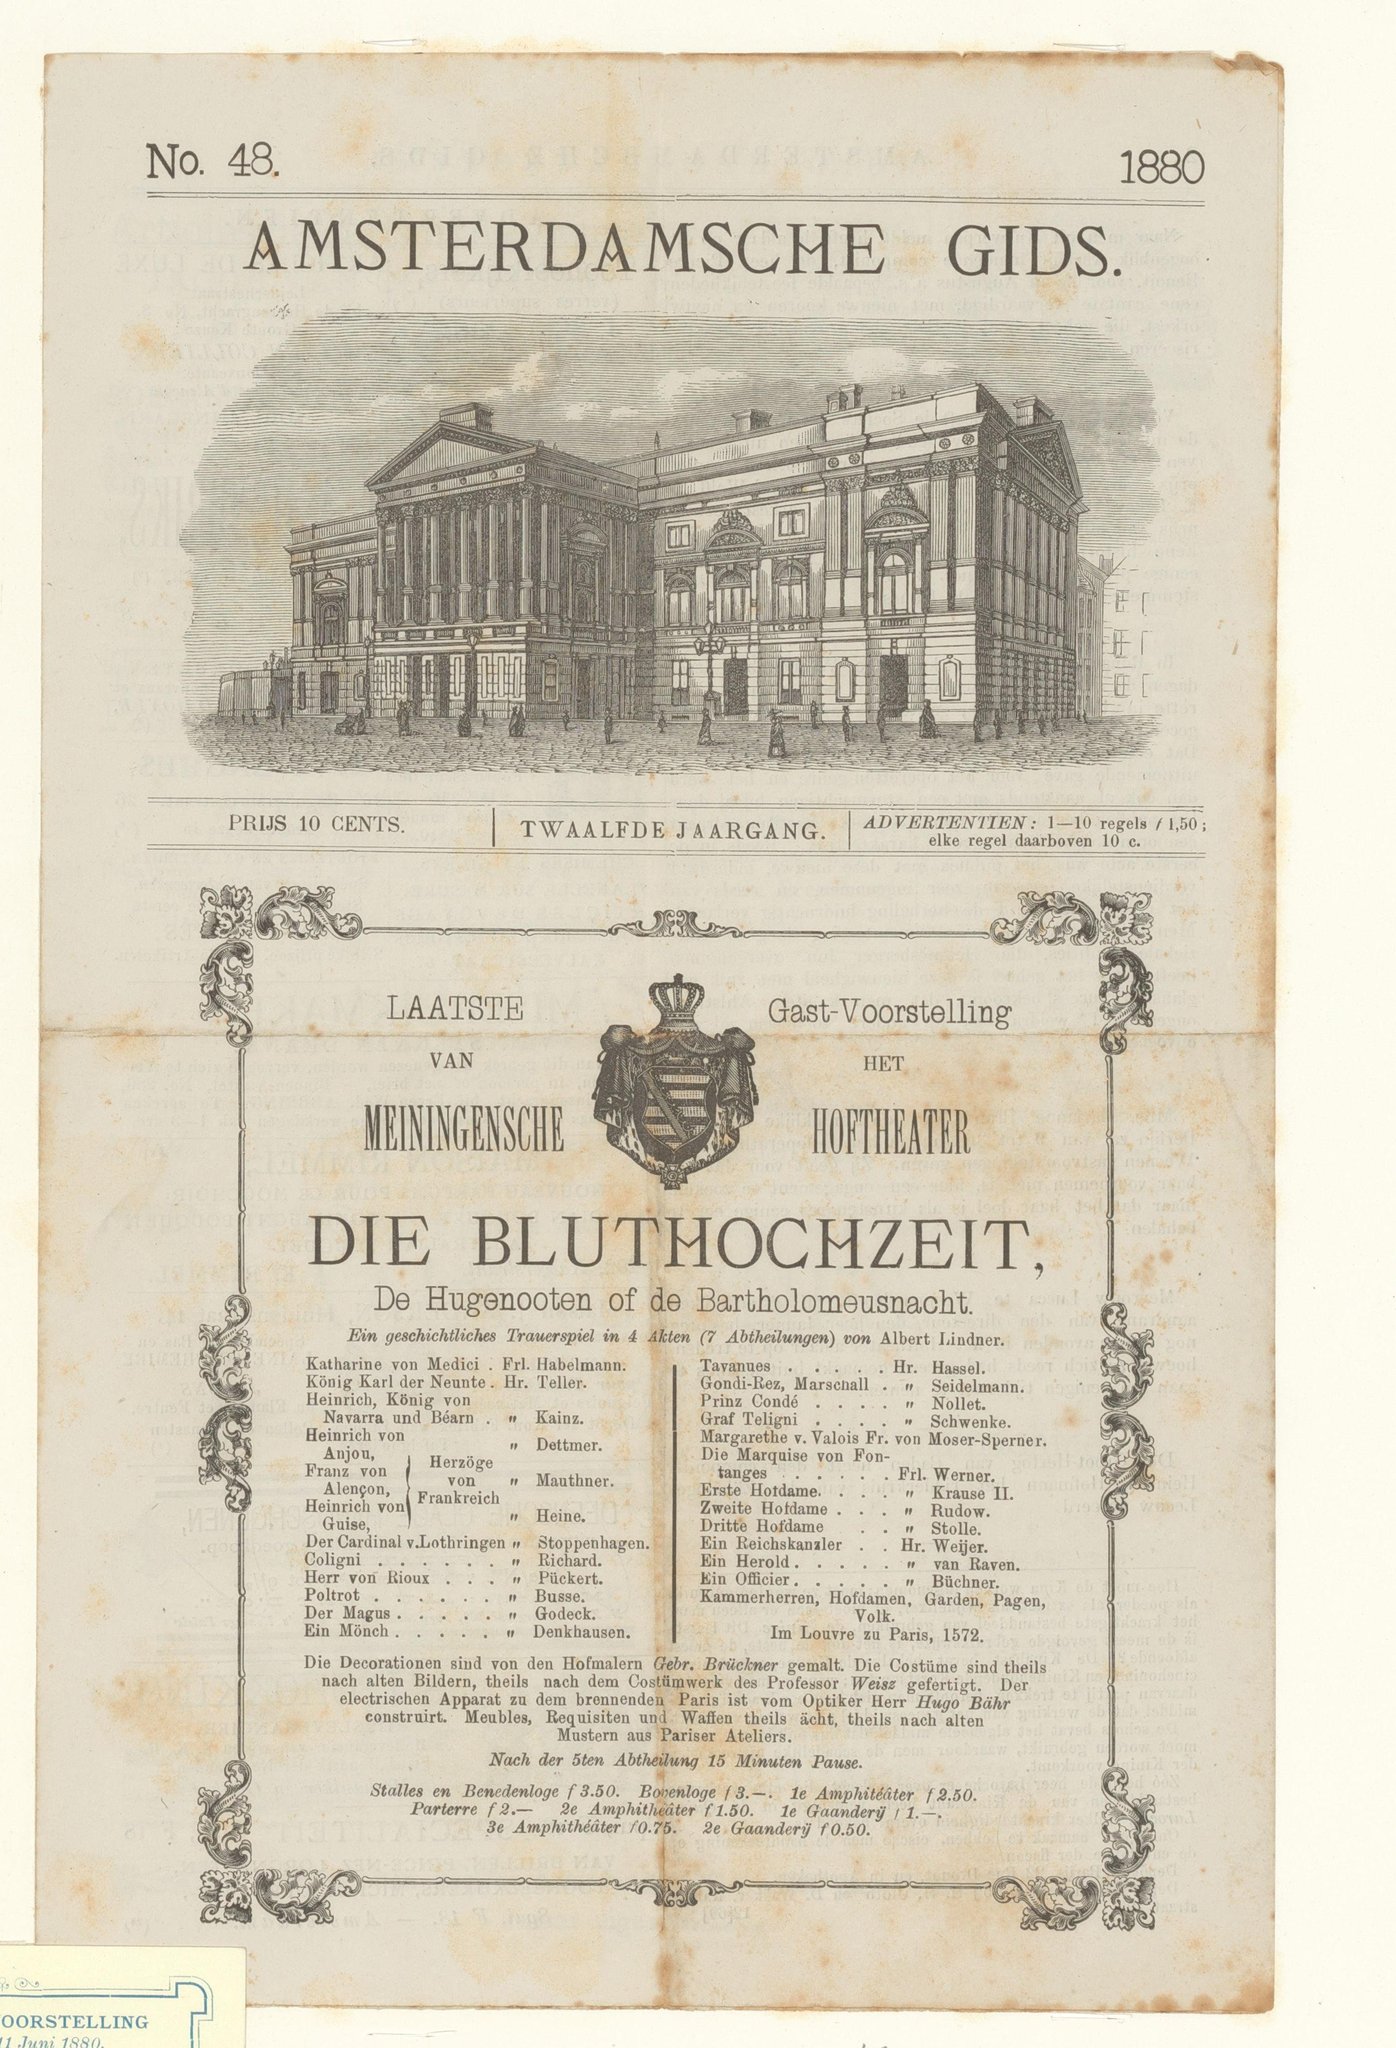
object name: text sheet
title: Amsterdamsche Gids en aankondiging voor de voorstelling Die Bluthochzeit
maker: Anonymous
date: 1880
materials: paper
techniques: letterpress printing, lithograph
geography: amsterdam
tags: theatre, theatrical performance, advertisement, notice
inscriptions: collector's mark: Lugt 1641, stamp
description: Een gevouwen blad vormt samen vier pagina's. Op de eerste pagina een aankondiging voor de voorstelling Die Bluthochzeit. Op de overige pagina's Nieuws uit de Kunstwereld en diverse advertenties. Linksboven genummerd: No. 48. Onderwerpsrubrieken binnen de Atlas Zeden en Gewoonten: Tooneel, Toneelprogramma’s.